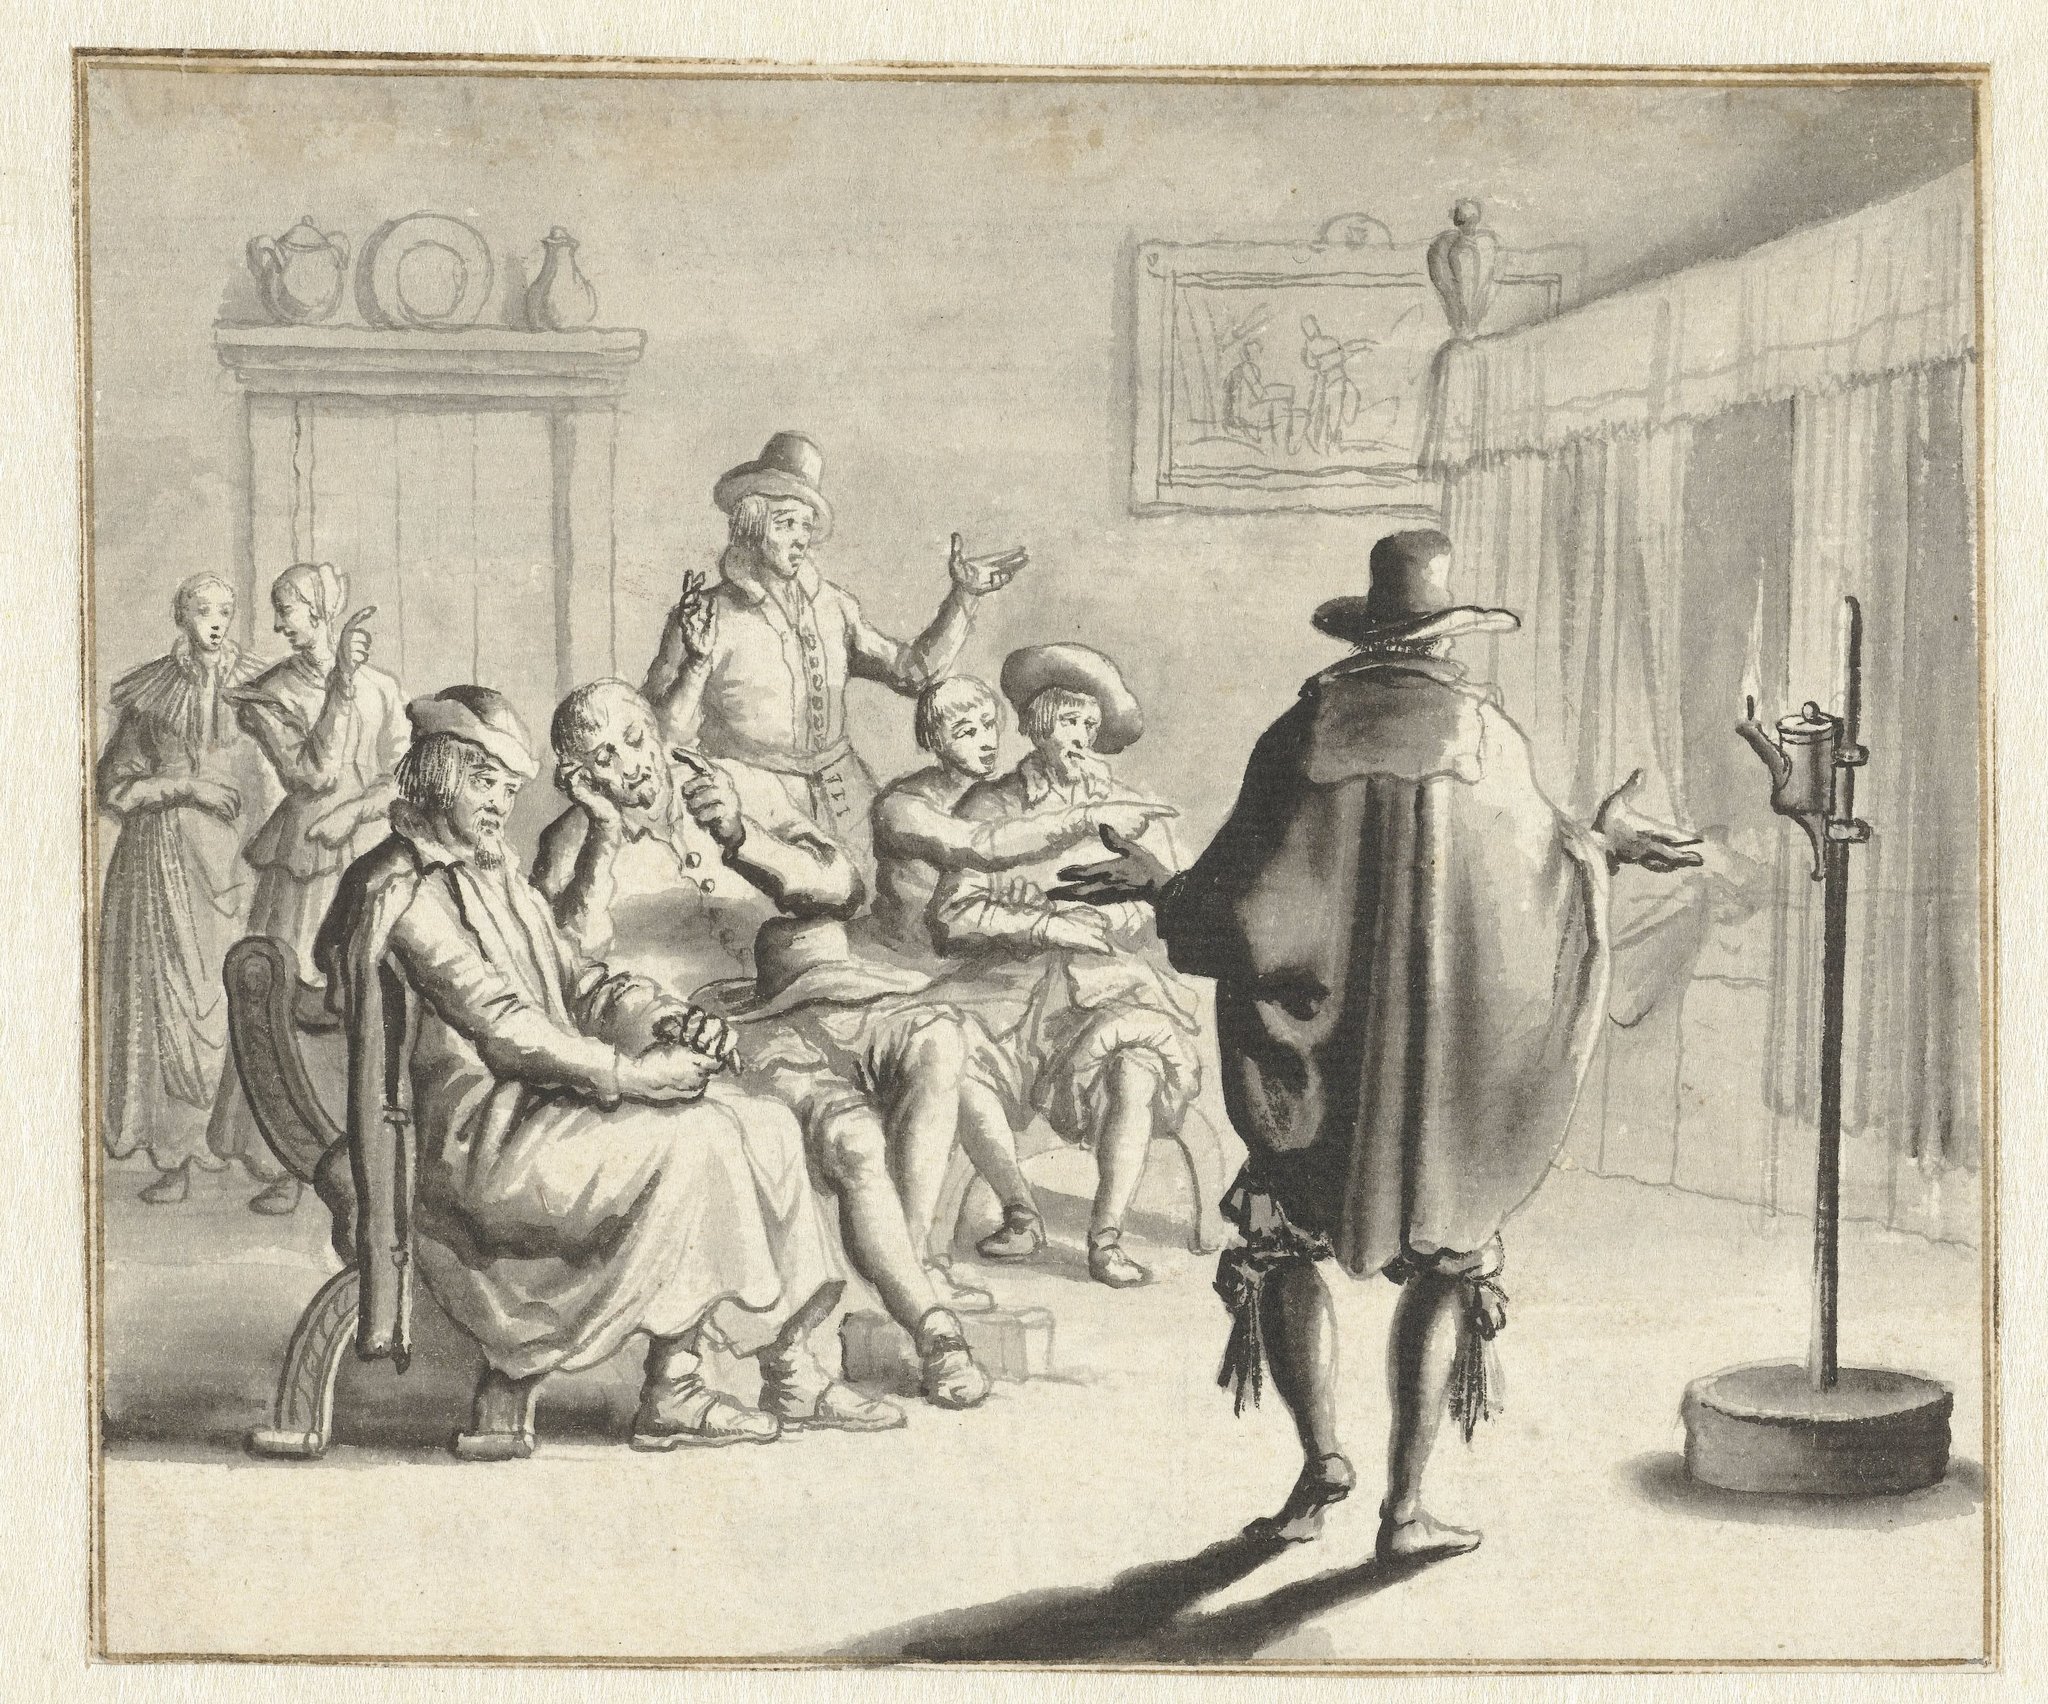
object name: drawing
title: Groep personen voor een bedstee waarin het spookt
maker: jan luyken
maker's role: draughtsman, print maker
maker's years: 1649-1712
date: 1660-1712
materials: ink, paper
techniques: brush, pen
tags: materialization, appearance of spirit or ghost, built-in bedstead (dutch: 'bedstee')